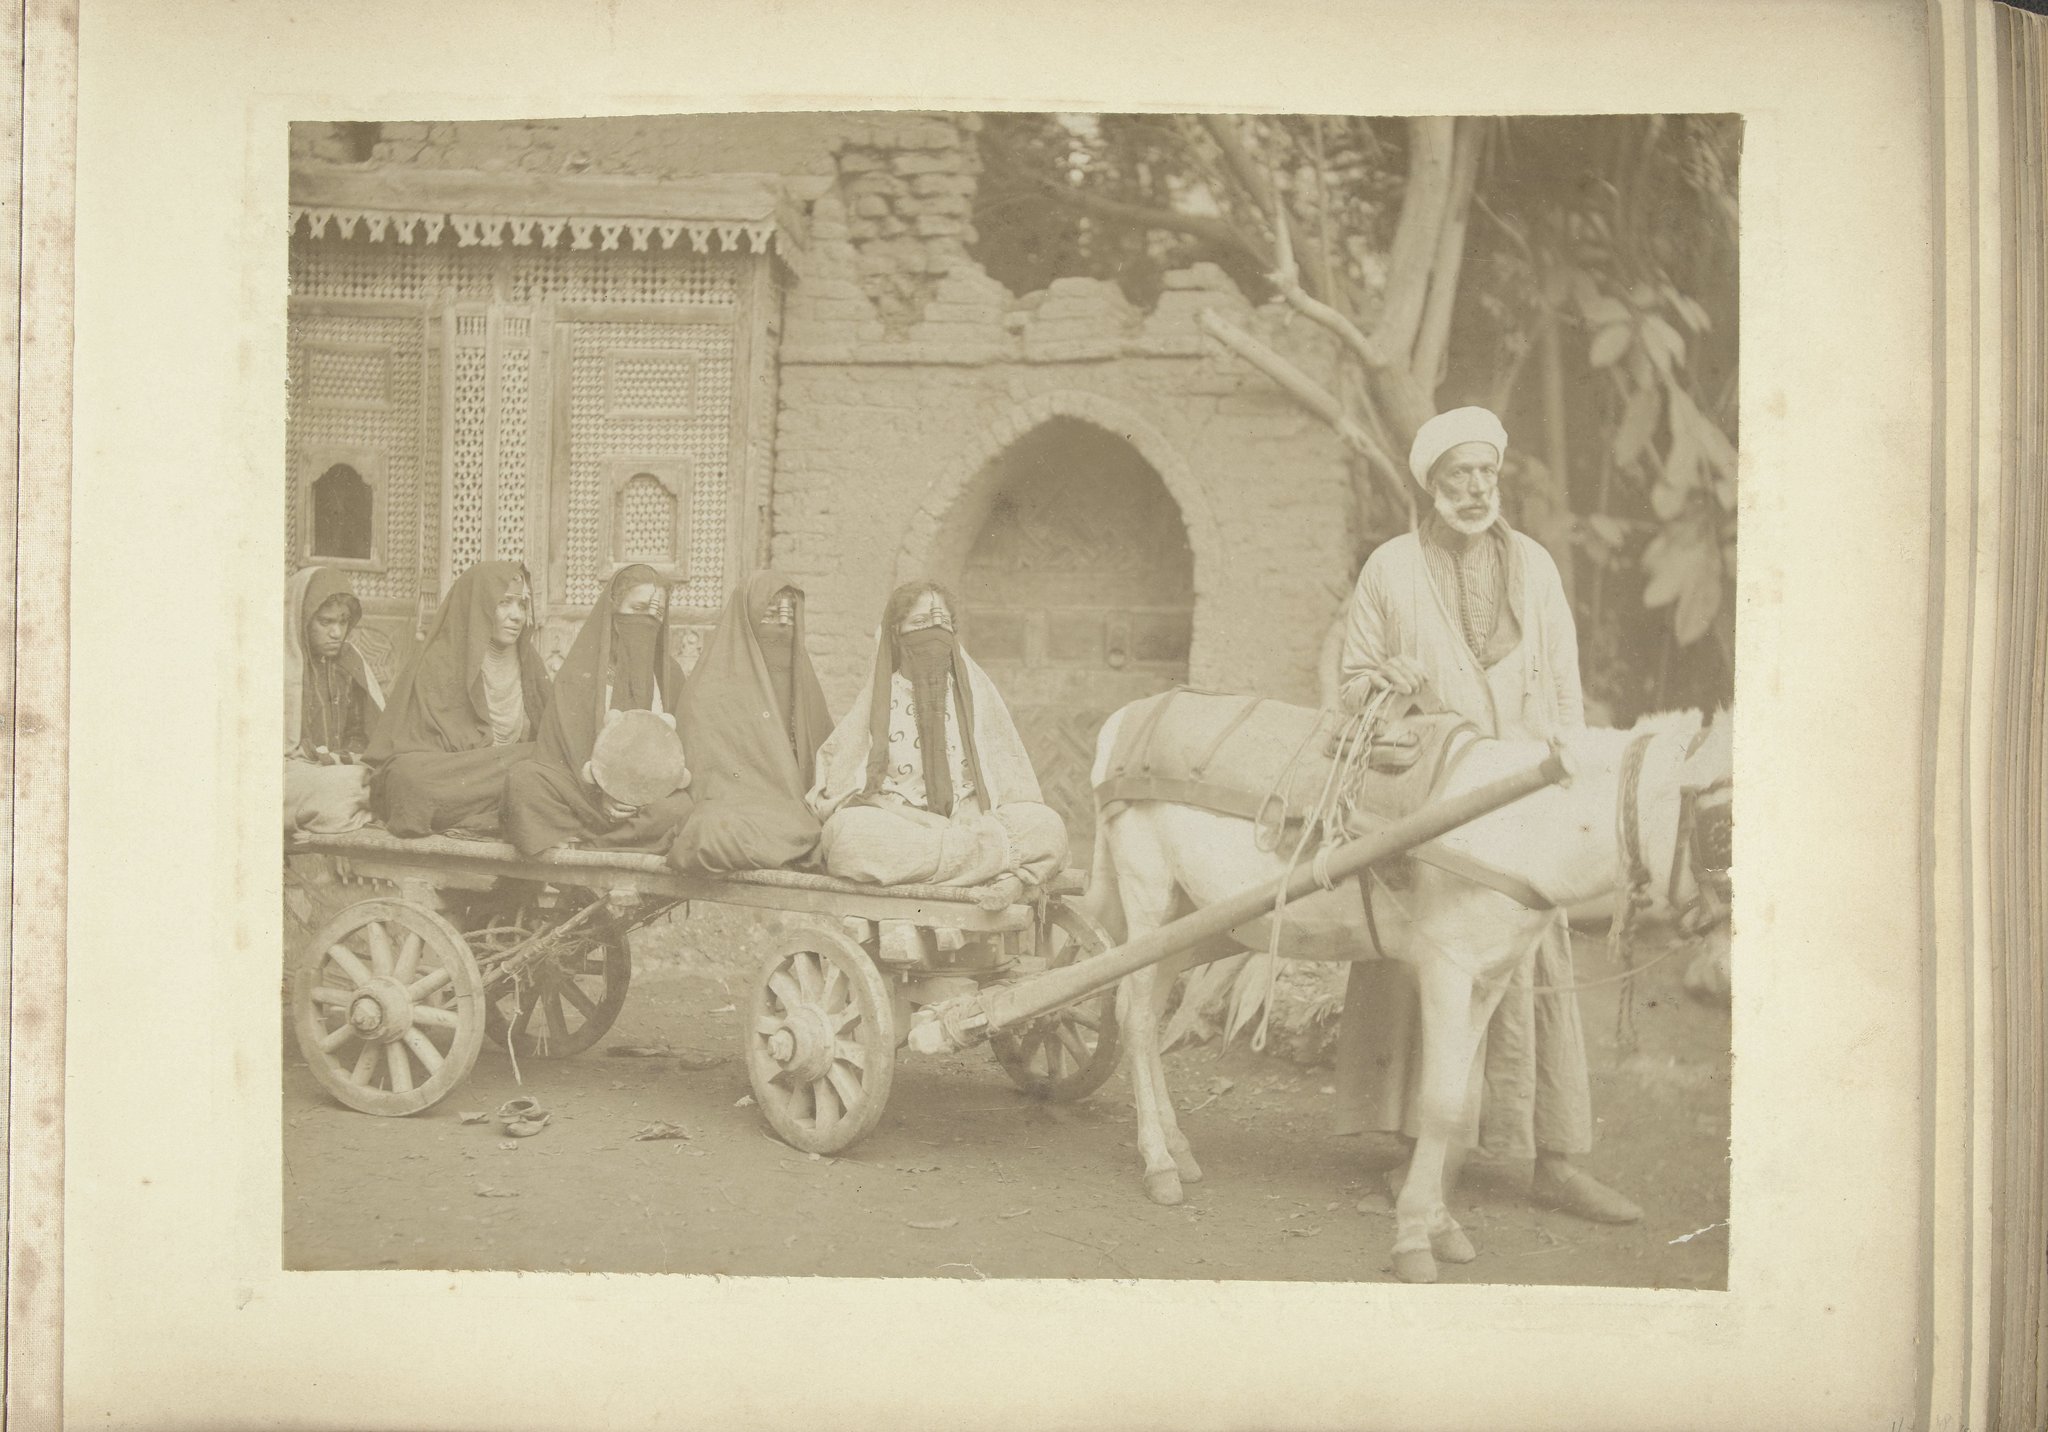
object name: album leaf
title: Gesluierde vrouwen zitten op een kar die wordt voortgetrokken door een ezel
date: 1887-1900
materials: paper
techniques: albumen print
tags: four-wheeled vehicle drawn by one animal, ass, donkey, historical persons - bb - woman, veil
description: De ezel wordt begeleid door een man met een tulband en baard